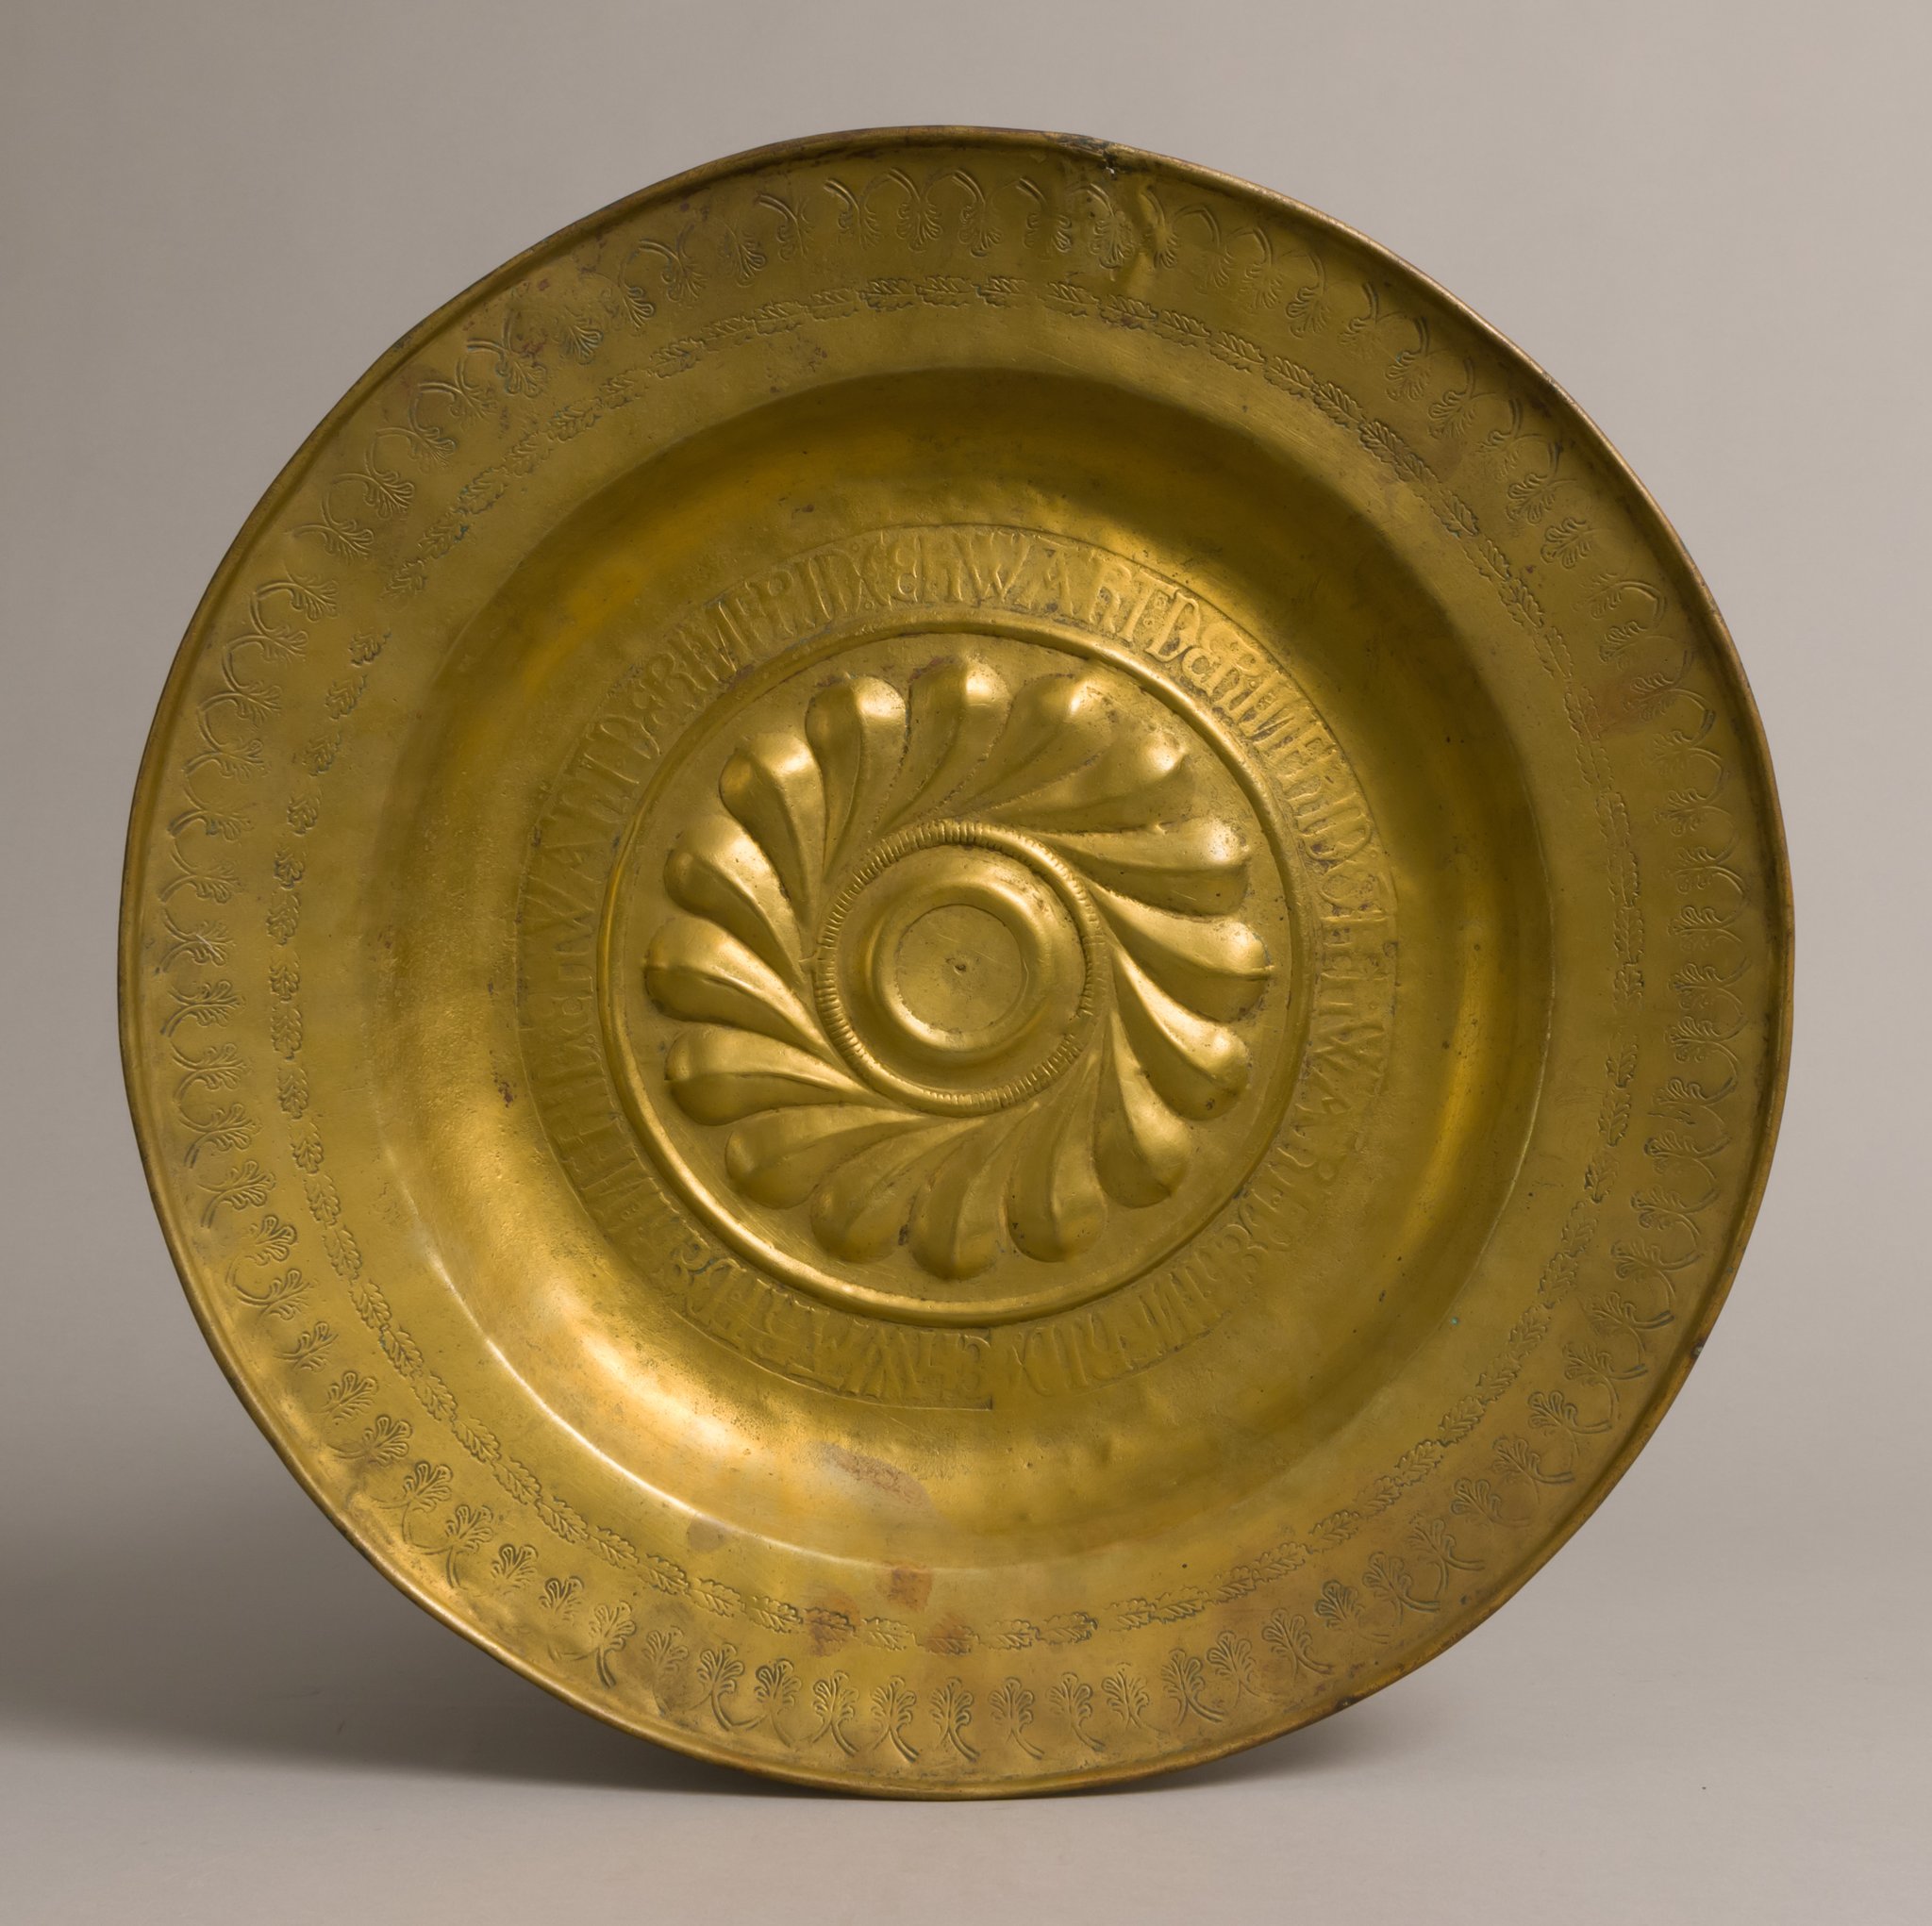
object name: dish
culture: german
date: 1501-1533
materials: brass